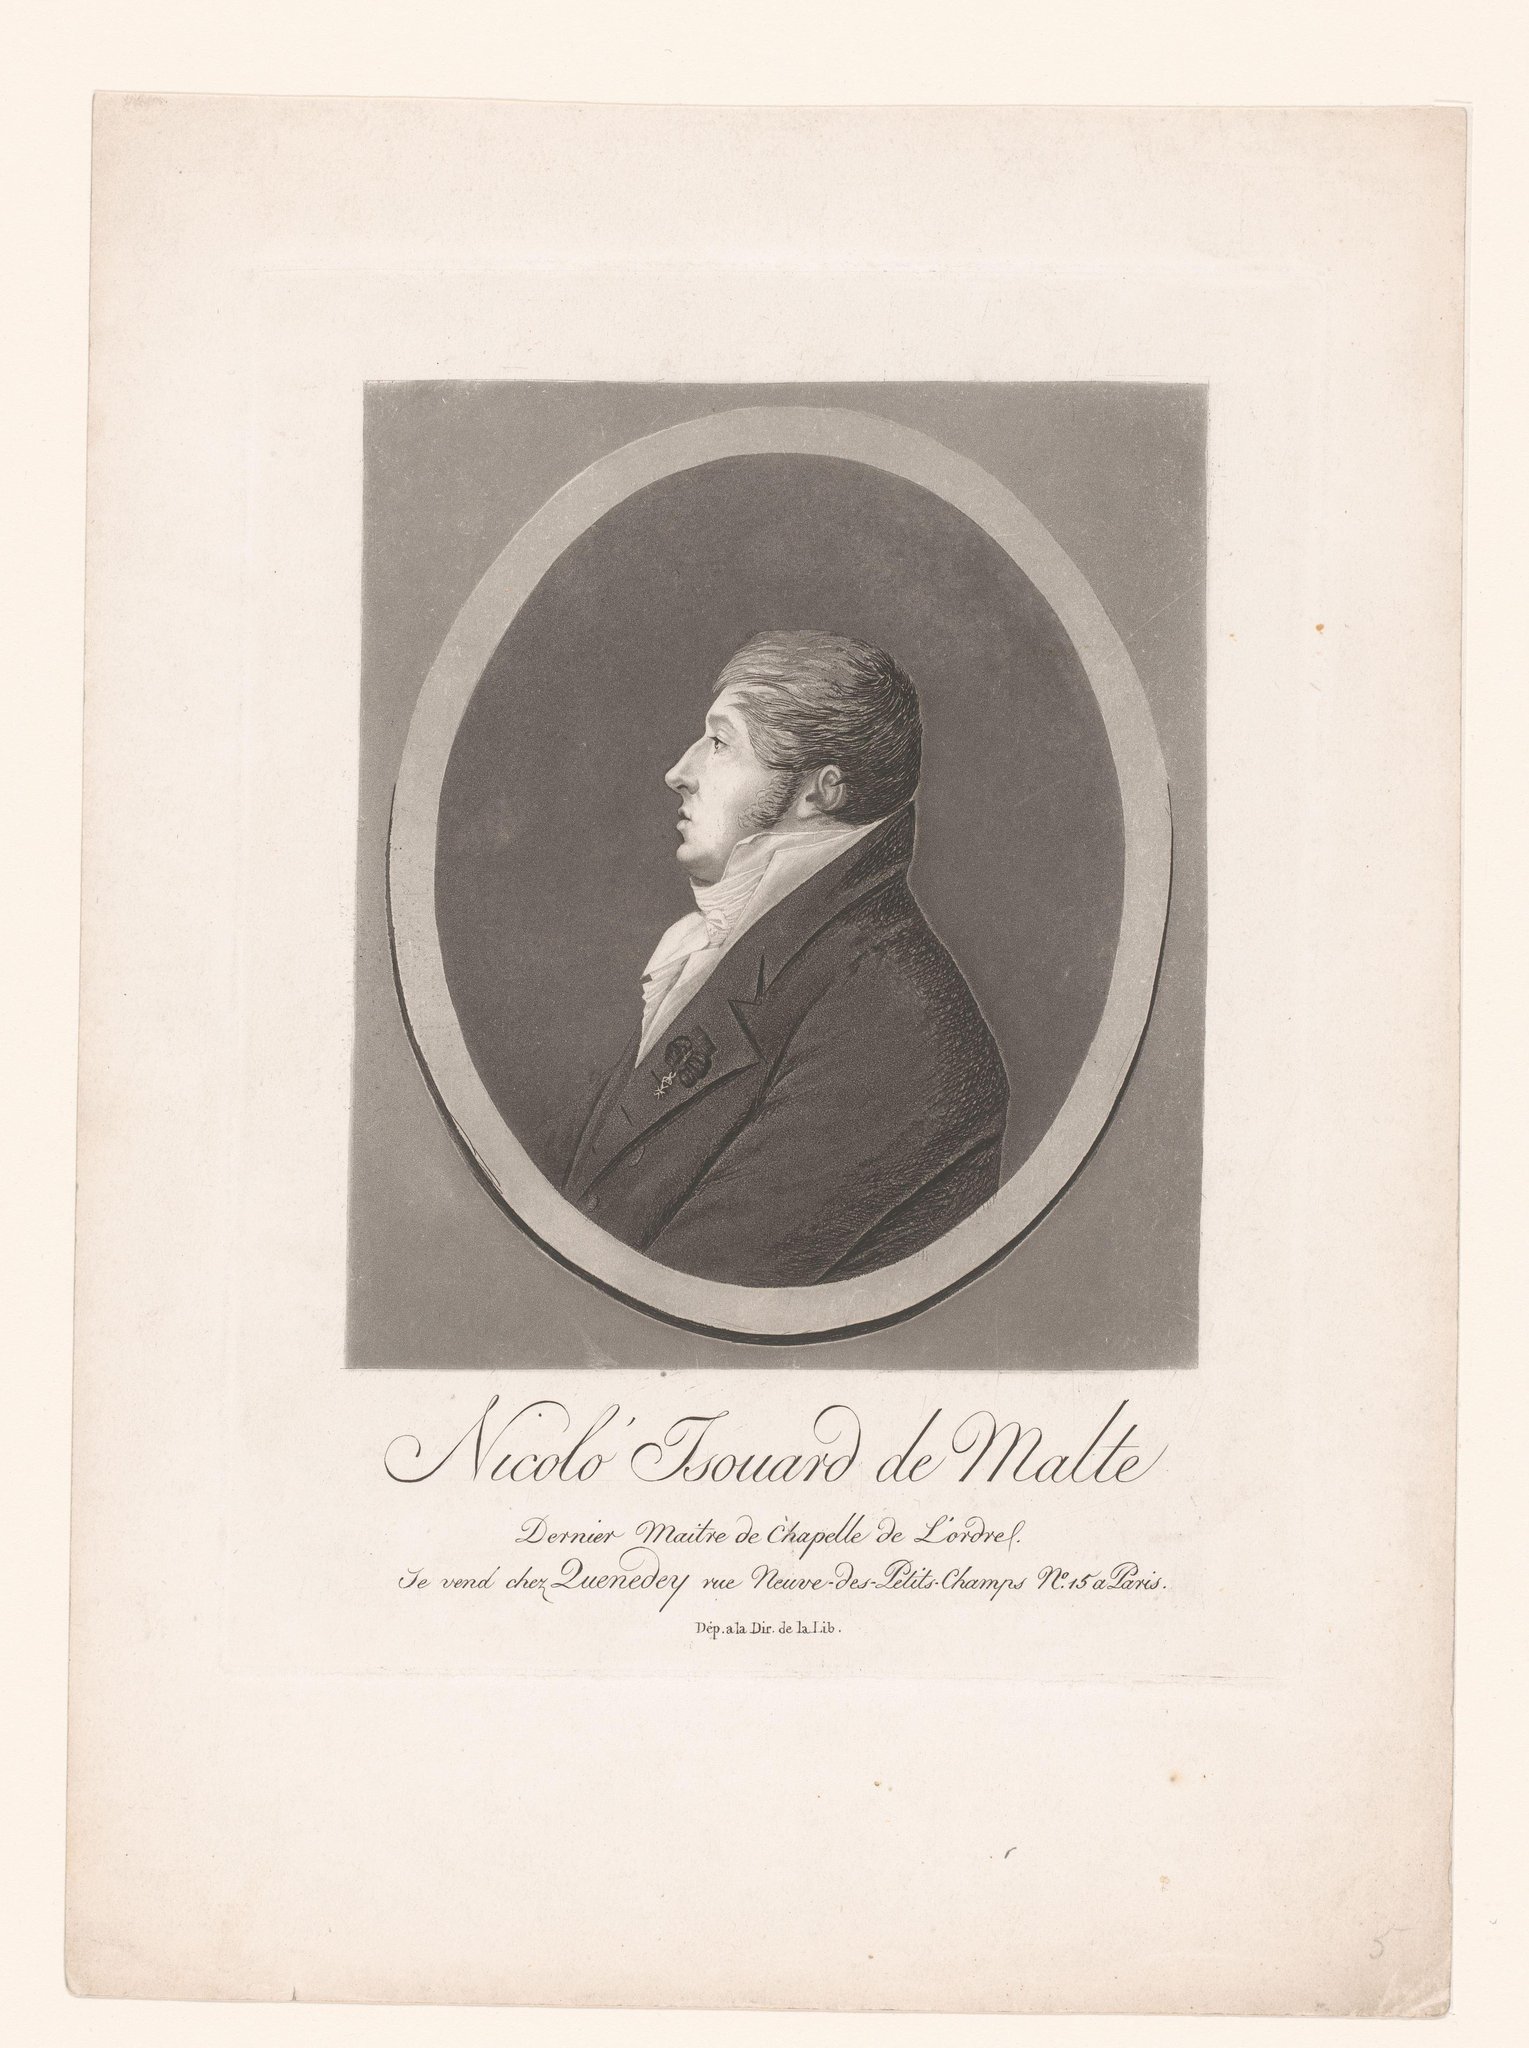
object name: print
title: Portret van Nicolas Isouard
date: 1780-1830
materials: paper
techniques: aquatint, etching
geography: paris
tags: historical persons, portrait of composer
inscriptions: : ‘Dép. a la Dir. de la Lib.’, collector's mark: Lugt 2228